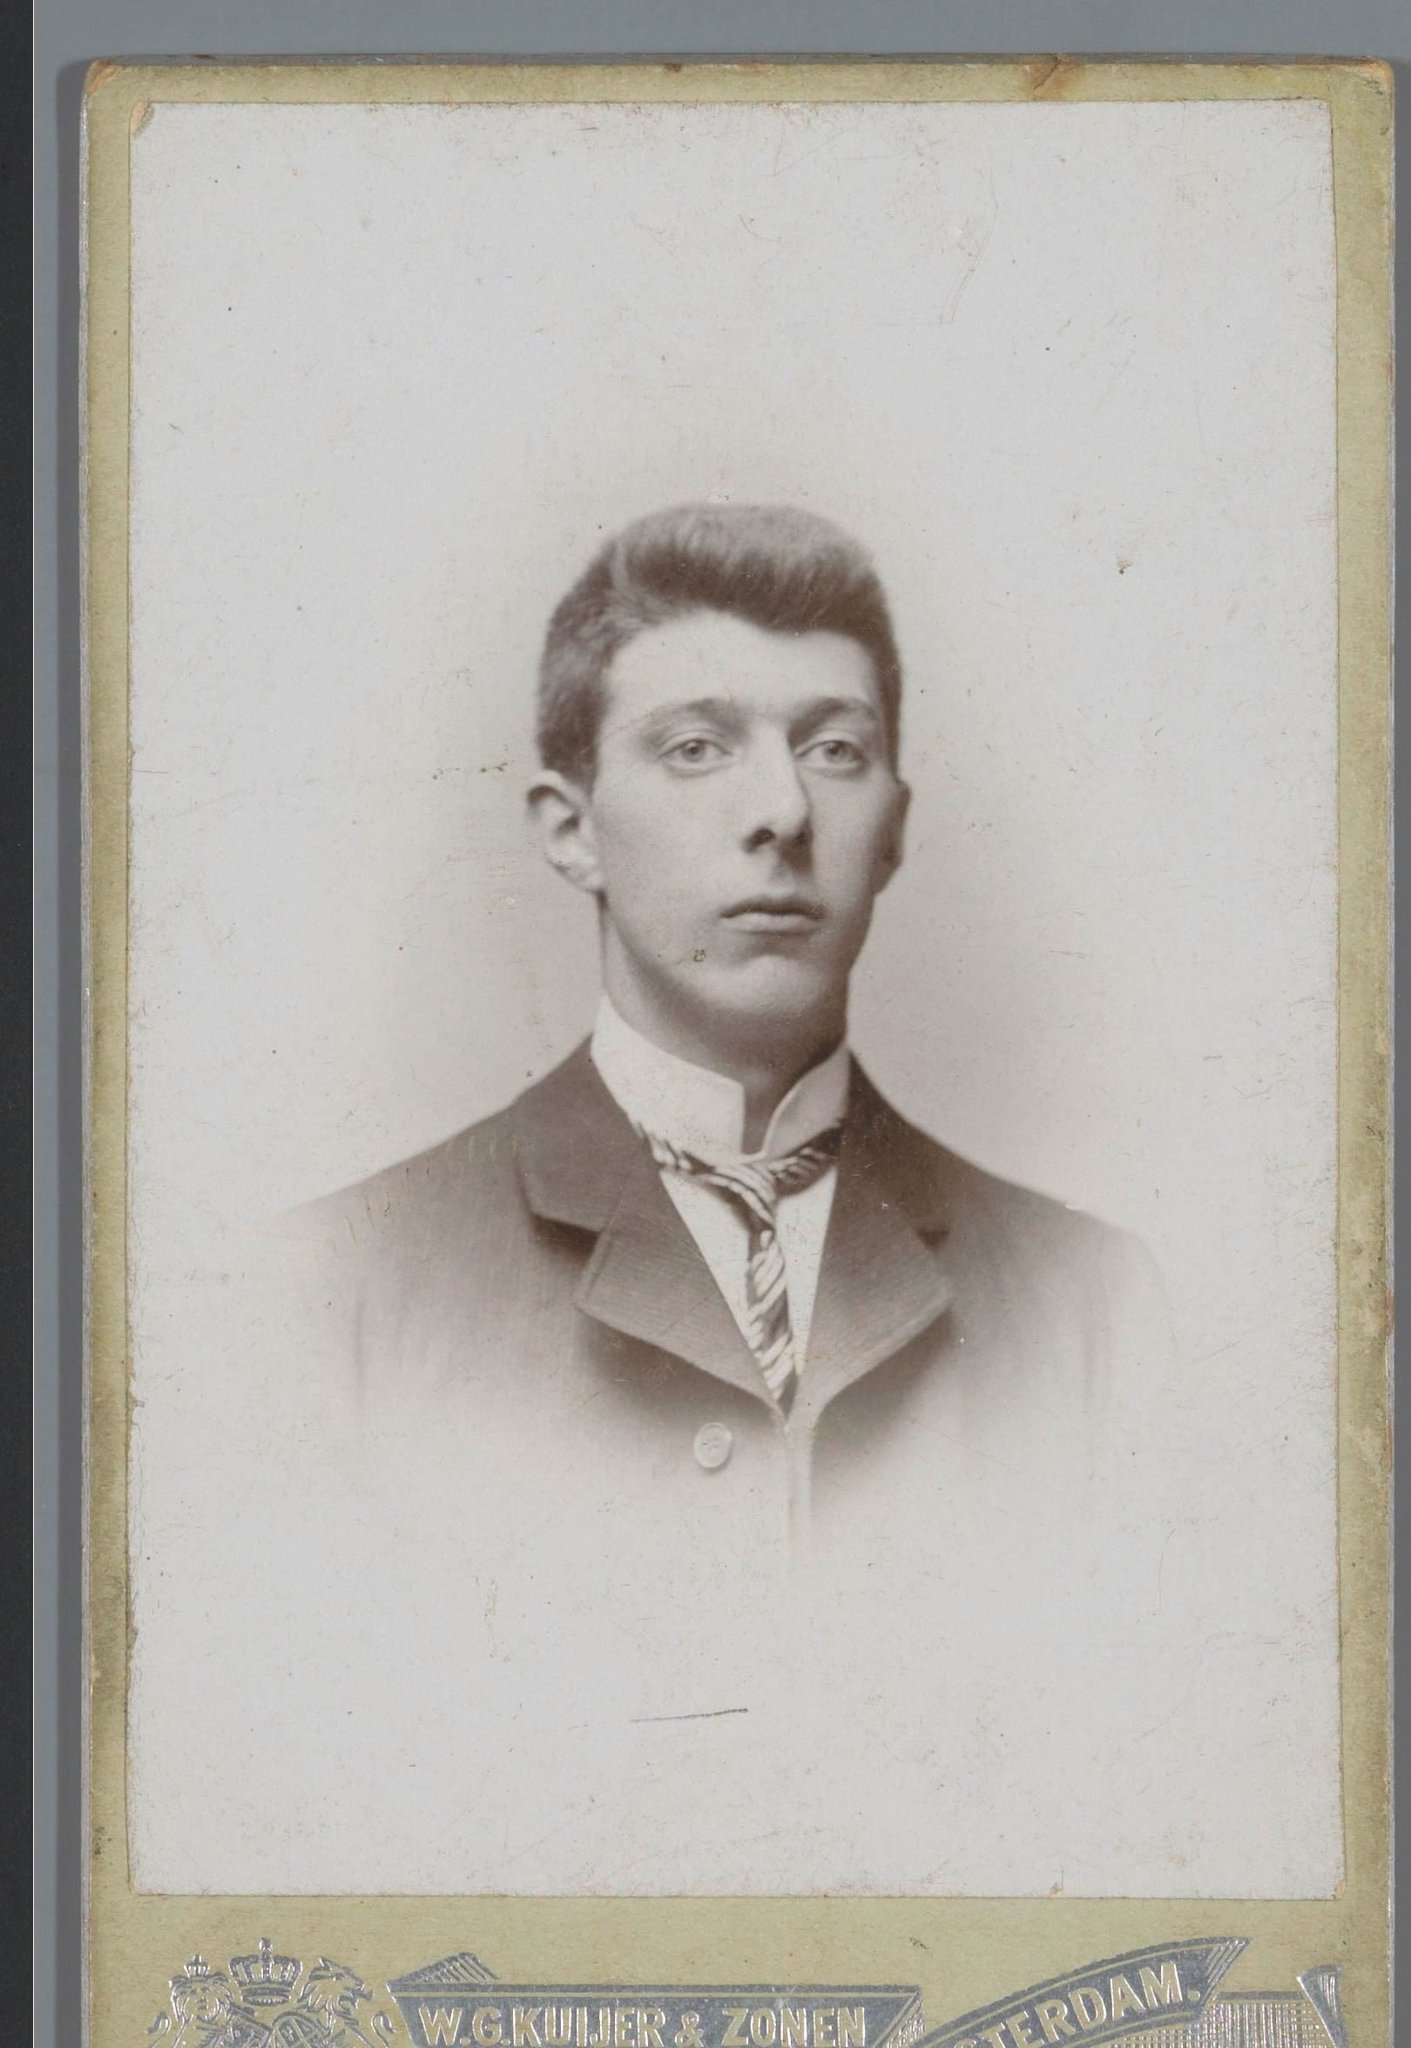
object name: photograph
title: Portret van een onbekende man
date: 1885-1906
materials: cardboard, photographic support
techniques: collodion silver print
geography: amsterdam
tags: adult man, historical persons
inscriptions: inscription: ‘OPGERICHT 1864/ W.G. Kuijer & Zonen/ Hofphotographen/ WESTERMARKT 19./ AMSTERDAM/ Spéciale Inrichting voor Vergrootingen in alle Formaten.’